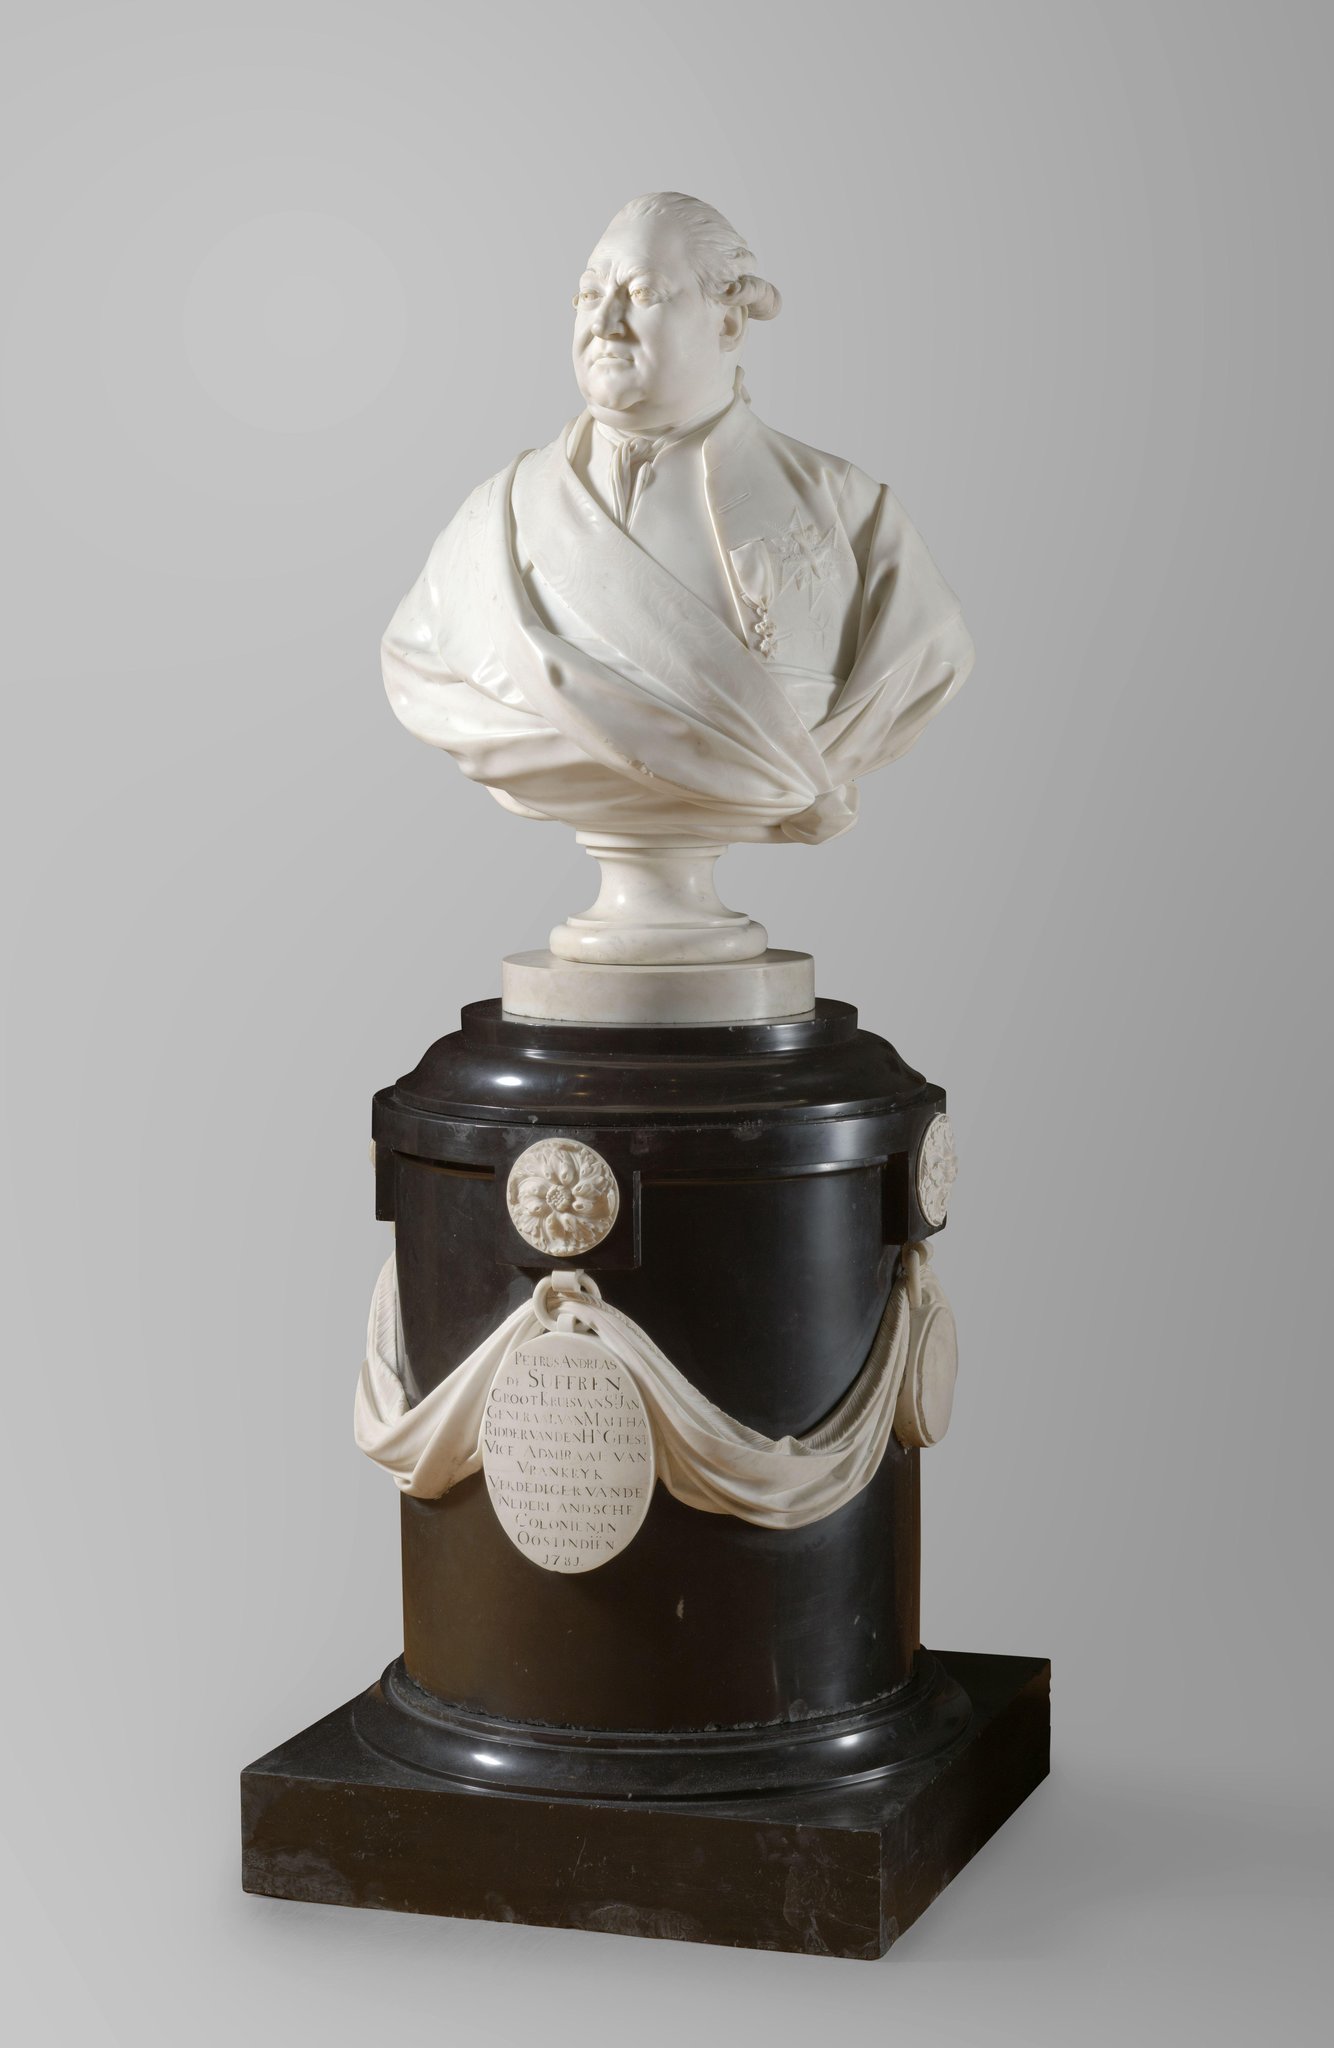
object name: bust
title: Bust of Pierre André de Suffren de Saint-Tropez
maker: jean antoine houdon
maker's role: sculptor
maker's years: 1741-1828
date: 1786-1787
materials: marble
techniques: chisel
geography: paris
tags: historical persons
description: The Fourth Anglo-Dutch War broke out in 1780. Britain attacked the Netherlands for supporting the American Revolution. The British besieged Dutch settlements in India and Ceylon, among other places. The diminished Dutch navy called upon the help of its ally, France. The French vice-admiral De Suffren defeated the British fleet in five naval battles.